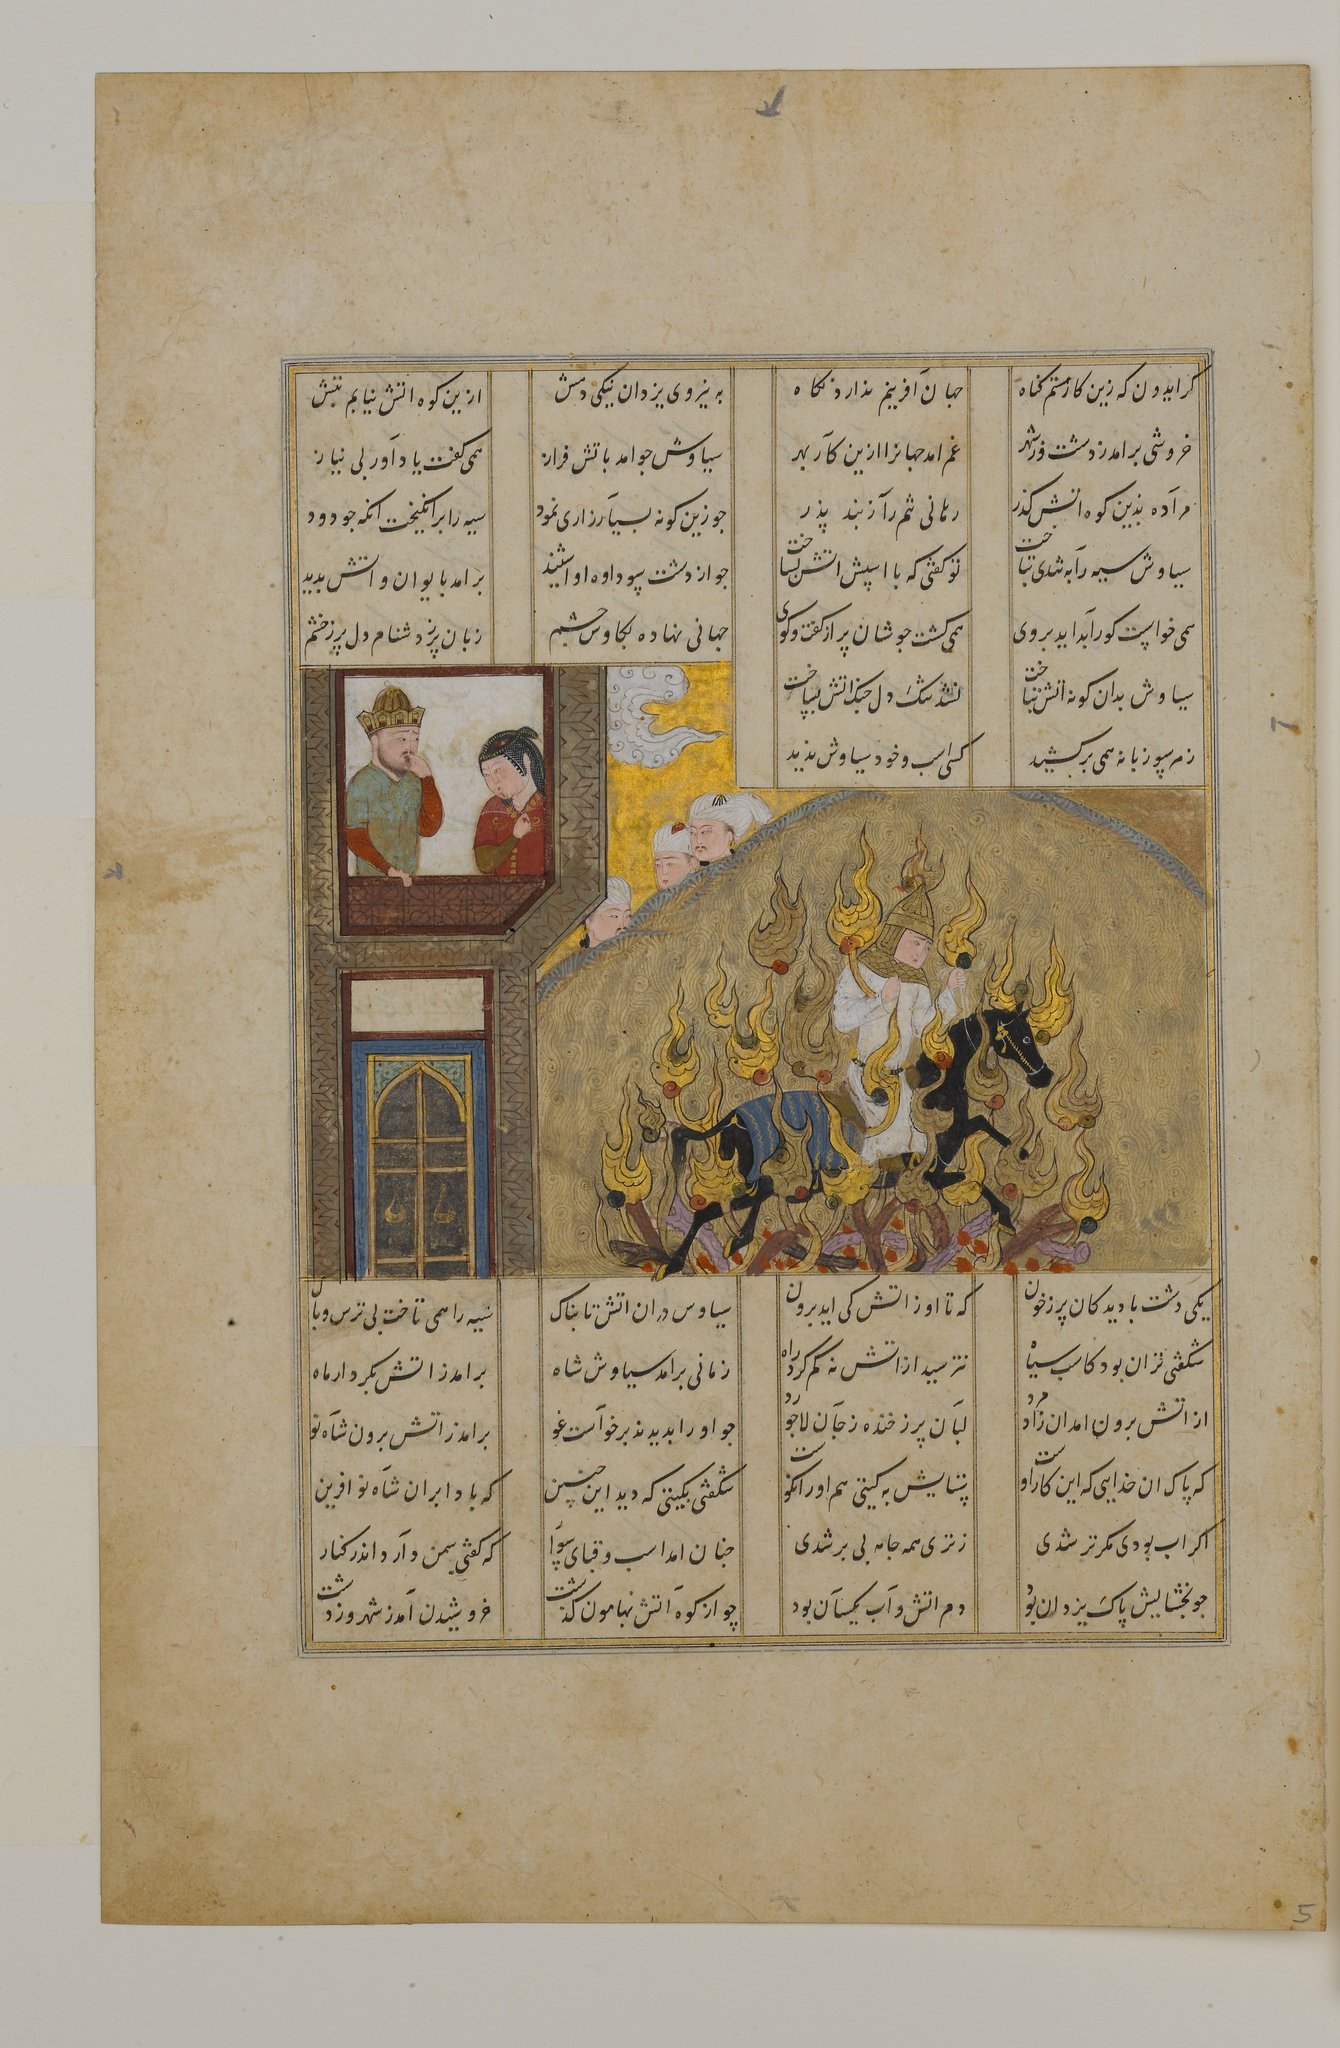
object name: folio from an illustrated manuscript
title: "The Fire Ordeal of Siyavush", Folio from a Shahnama (Book of Kings) of Firdausi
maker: abu'l qasim firdausi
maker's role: author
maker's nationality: iranian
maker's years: 935-1020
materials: gold, ink, paper, watercolor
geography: iran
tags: men,women,horses,fire